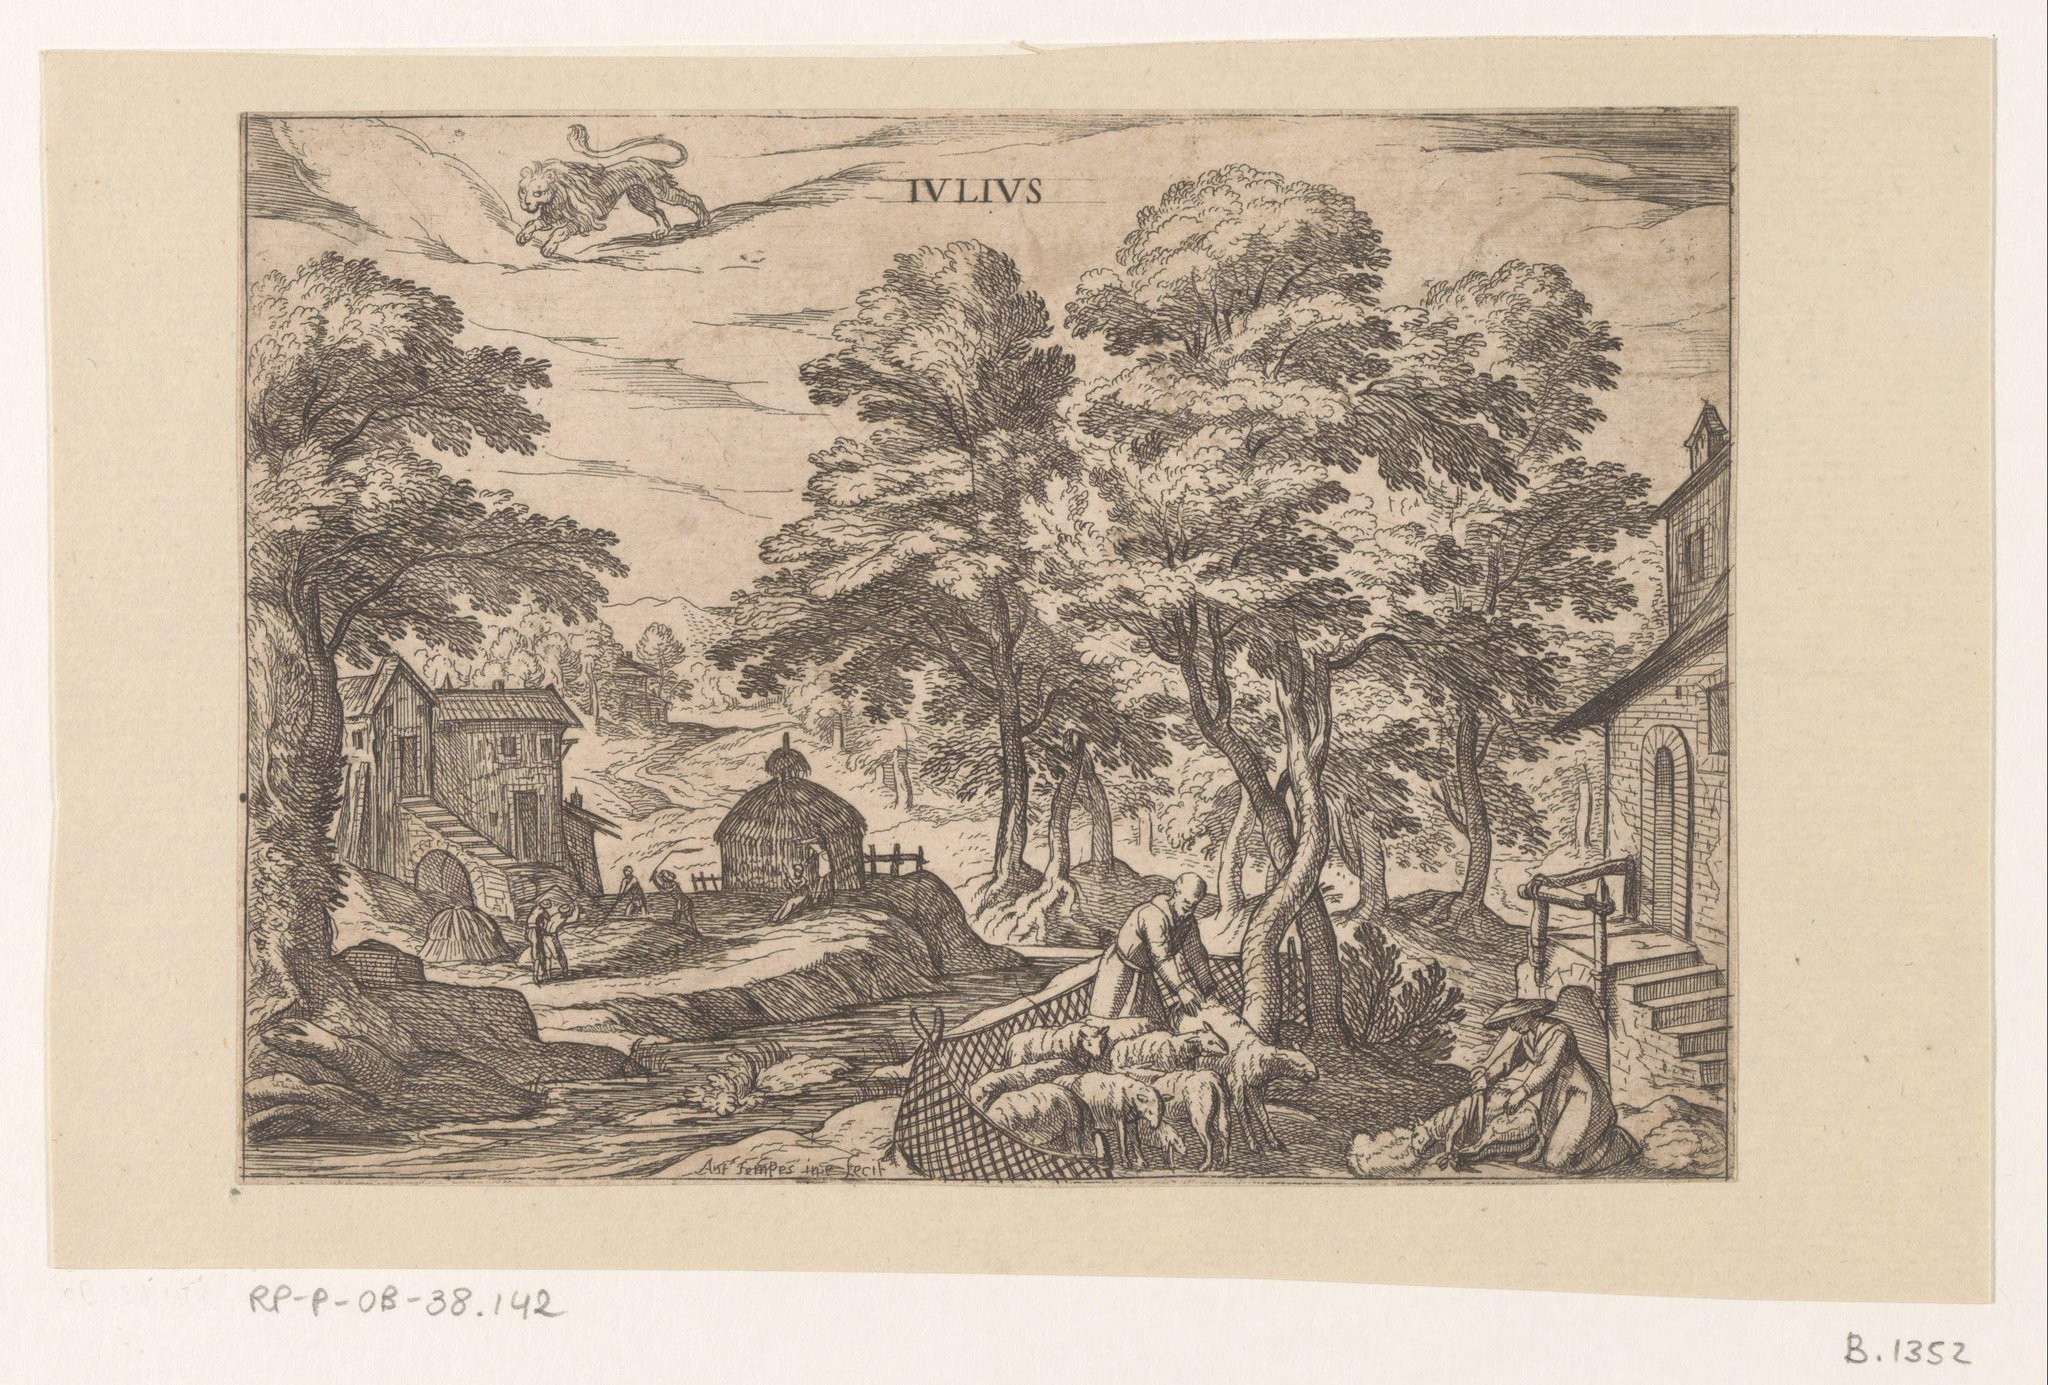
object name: print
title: Juli: schapen scheren (leeuw)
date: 1575-1613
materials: paper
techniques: etching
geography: italy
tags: leo (zodiacal sign of july), shearing (sheep), landscape symbolizing july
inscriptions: collector's mark: Lugt 240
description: Landschap dat de maand juli verbeeldt. Landschap met schapenscheerders. Linksboven het symbool voor het sterrenbeeld leeuw.